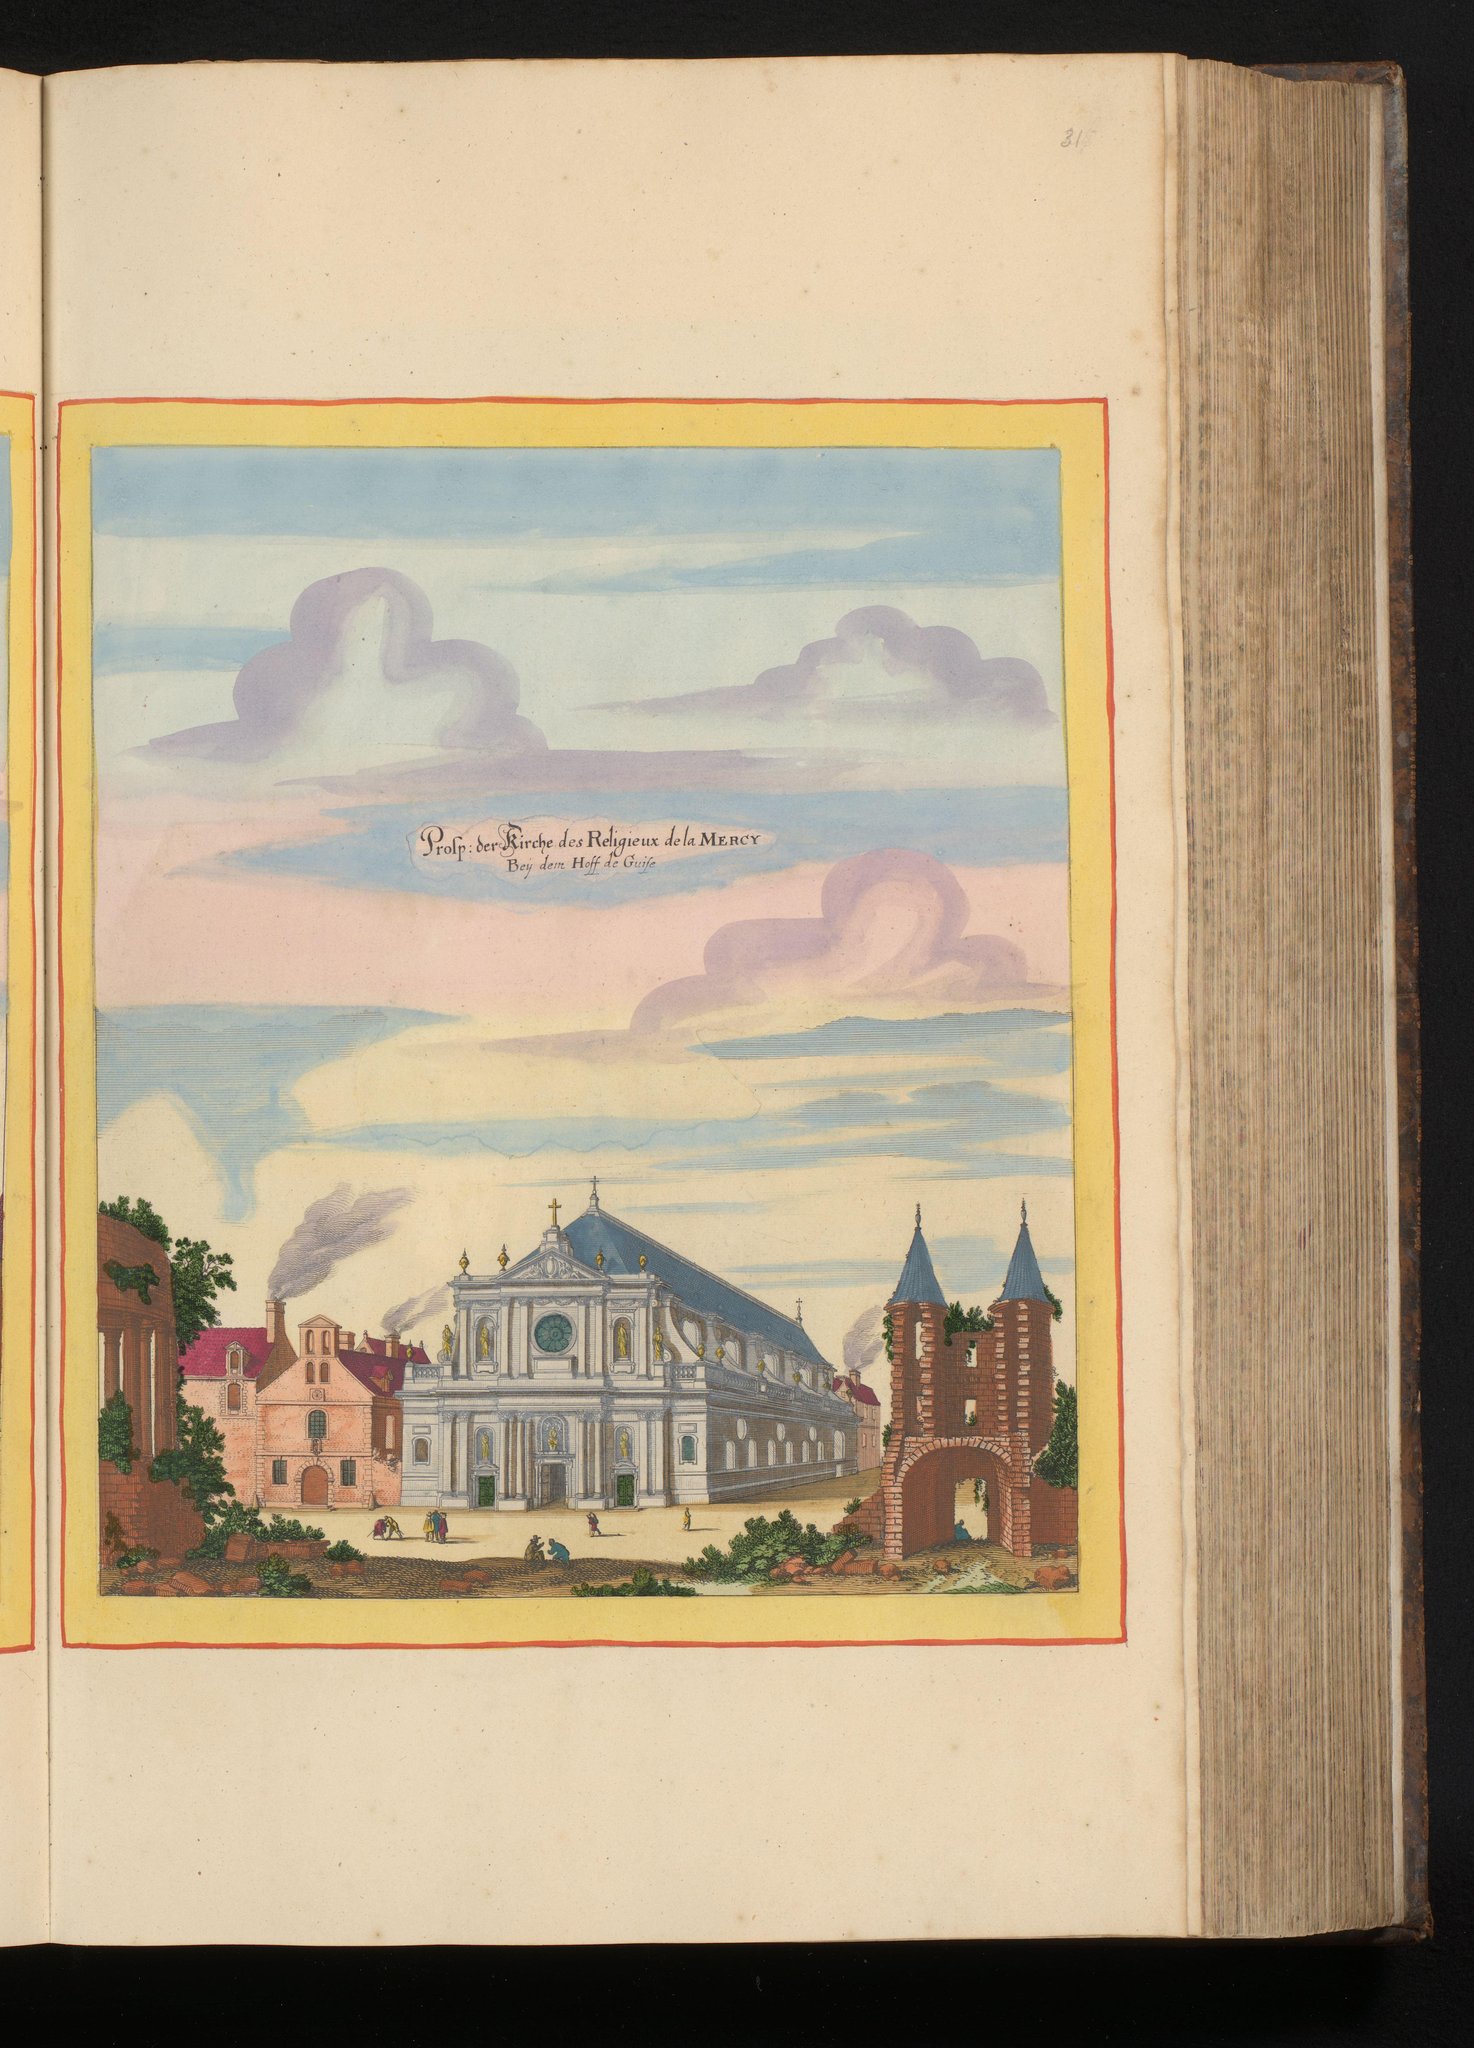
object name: print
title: Prosp. der Kirche des Religieux de la Mercy Beij dem Hoff de Guise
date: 1655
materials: paper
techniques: engraving, etching, hand coloring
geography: frankfurt am main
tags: church (exterior)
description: Prent origineel vervaardigd als boekillustratie voor: Zeiller, Martin. Topographia Galliae, oder Beschreibung und Contrafaitung der vornehmbsten und bekantisten Oerter in dem mächtigen und grossen Königreich Frankreich, 13 delen. Frankfurt am Main: Caspar Merian, 1655-1661. De prent werd voor het eerst gepubliceerd in deel 1: Topographia Galliae, 1655.